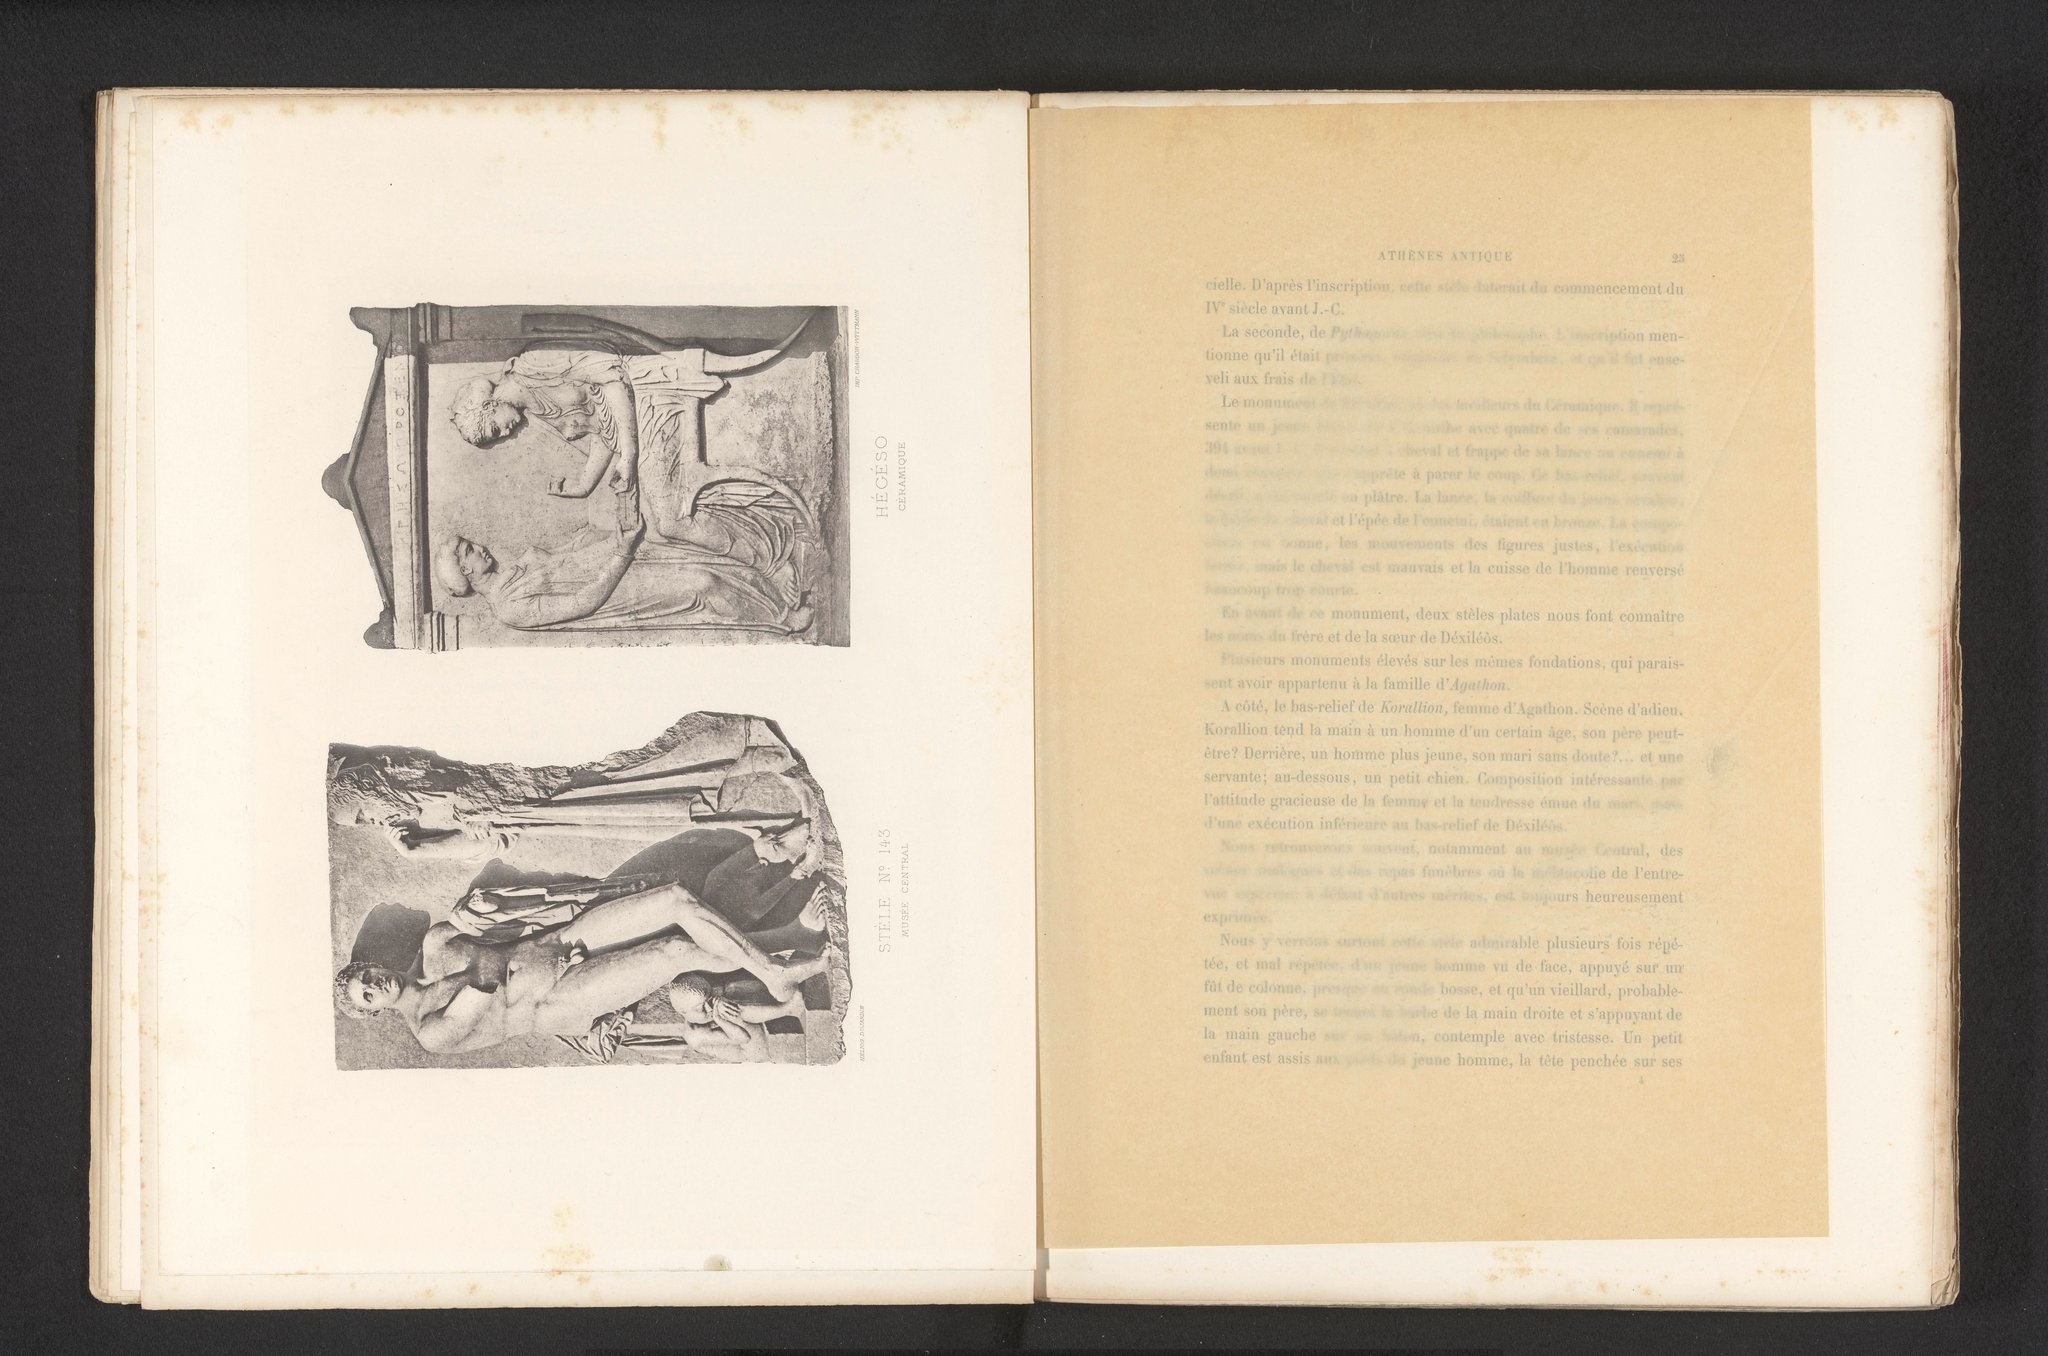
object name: photomechanical print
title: Hégéso céramique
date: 1880-1890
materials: paper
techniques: photoaquatint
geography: athens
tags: upright gravestone, sculpture (+ relief ~ sculpture)